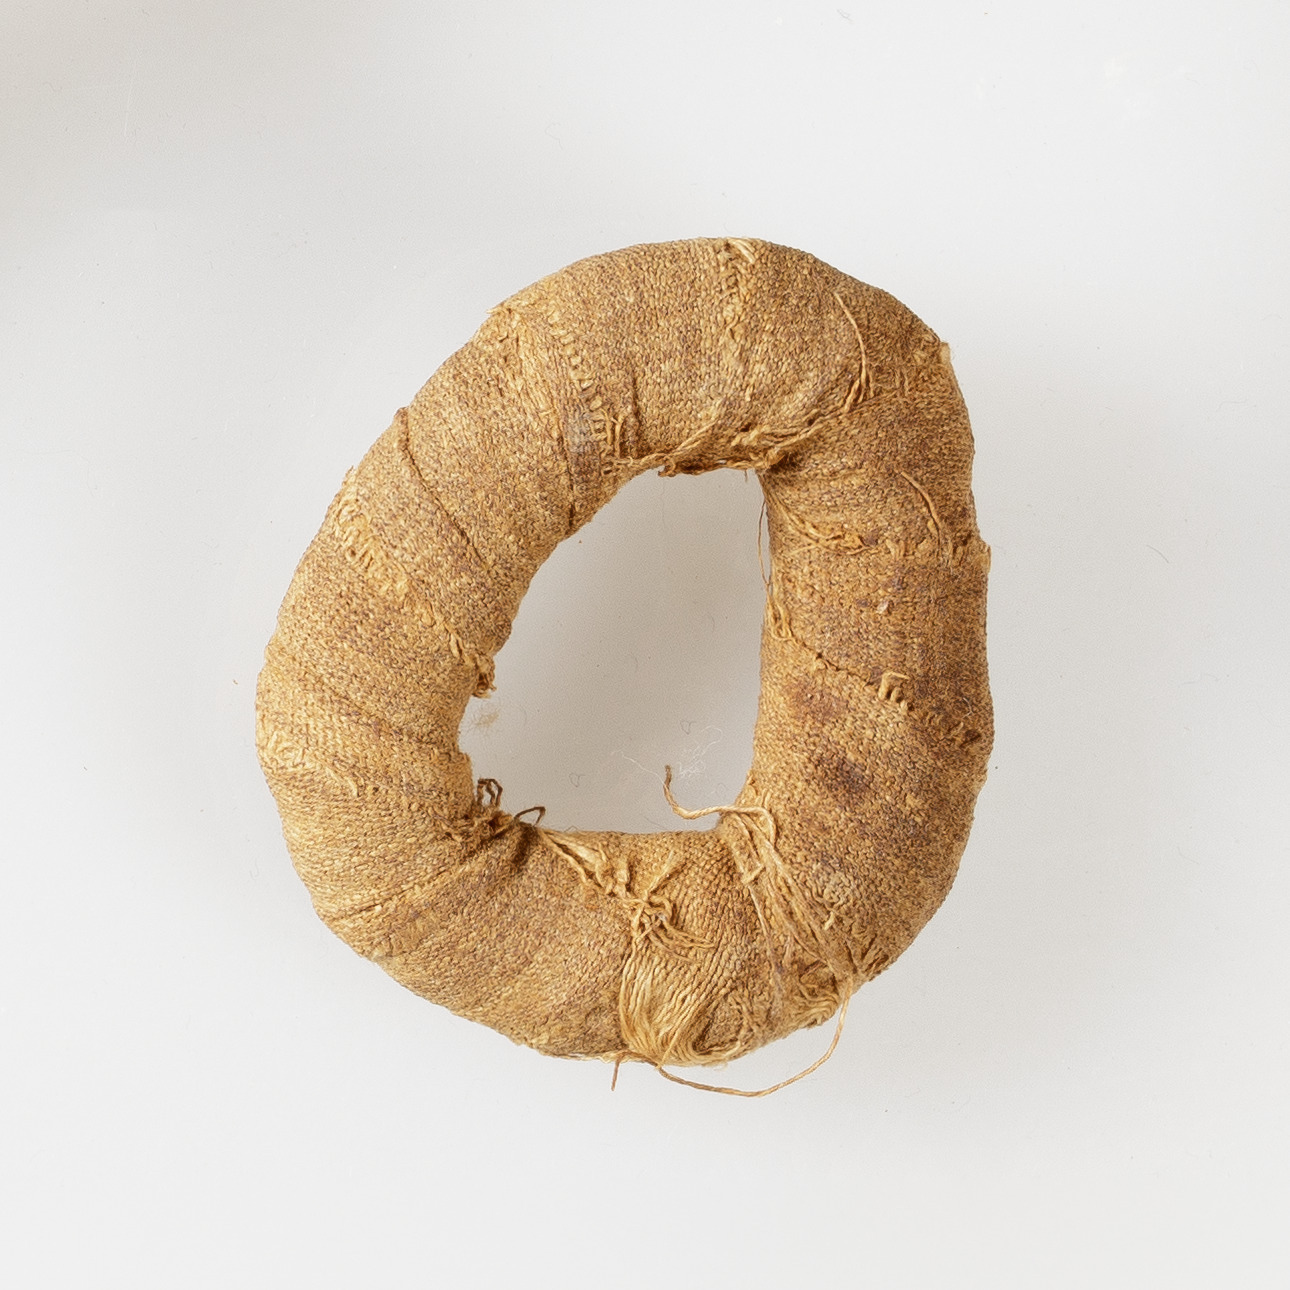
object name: vessel stand, ring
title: Ring stand for vessel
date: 945-525 BCE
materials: linen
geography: egypt